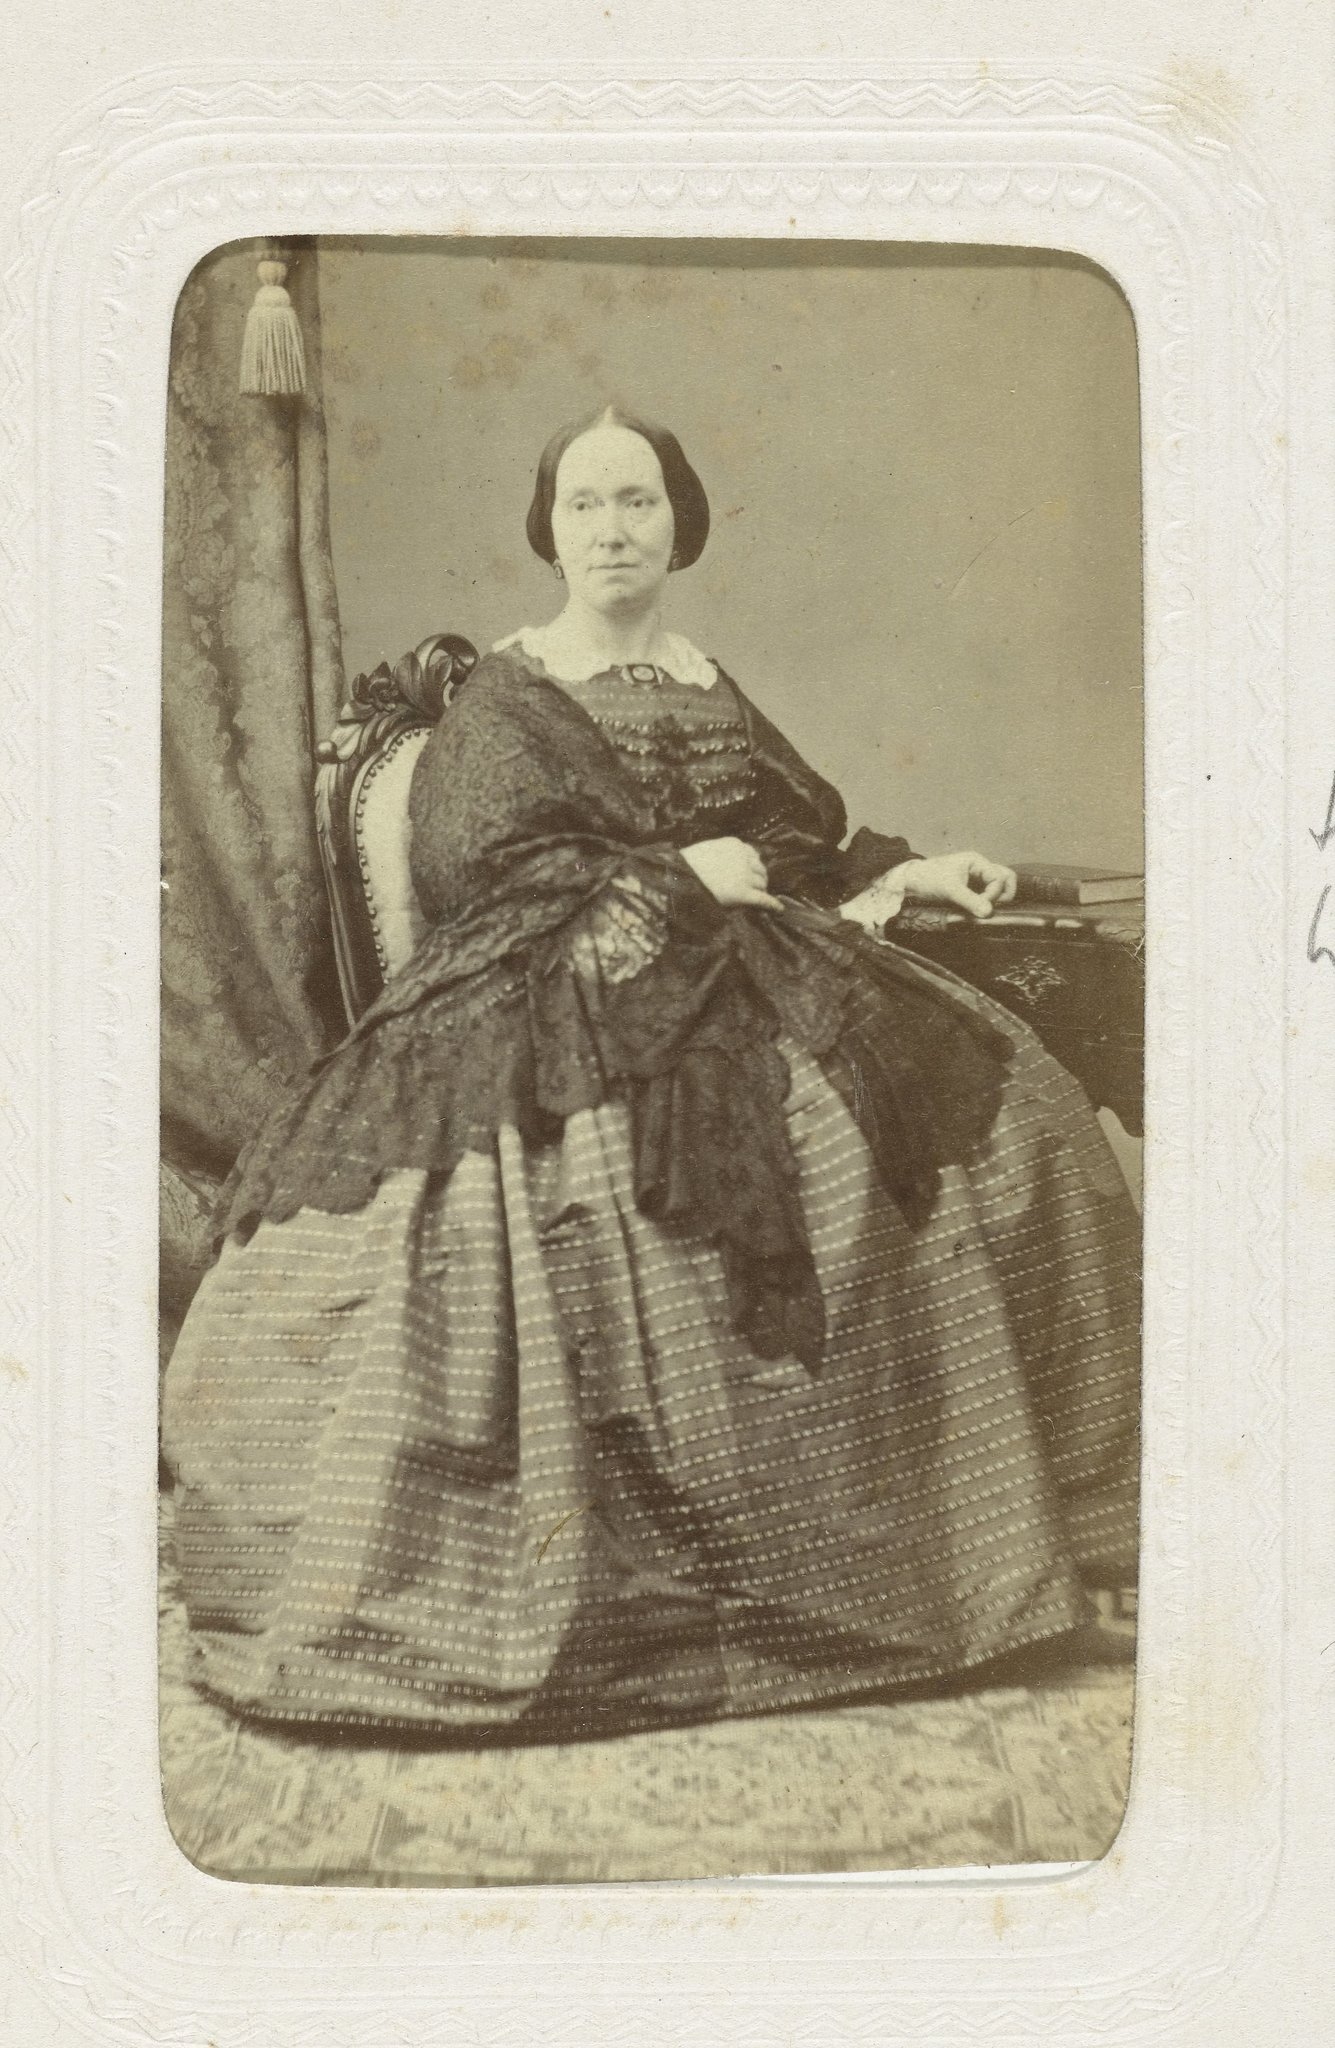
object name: carte de visite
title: Studioportret van een vrouw in een bolle jurk, zij zit aan een dressoir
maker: heinrich löwenstein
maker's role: artist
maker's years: 1806-1841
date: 1863-1866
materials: cardboard, paper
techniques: albumen print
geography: amsterdam